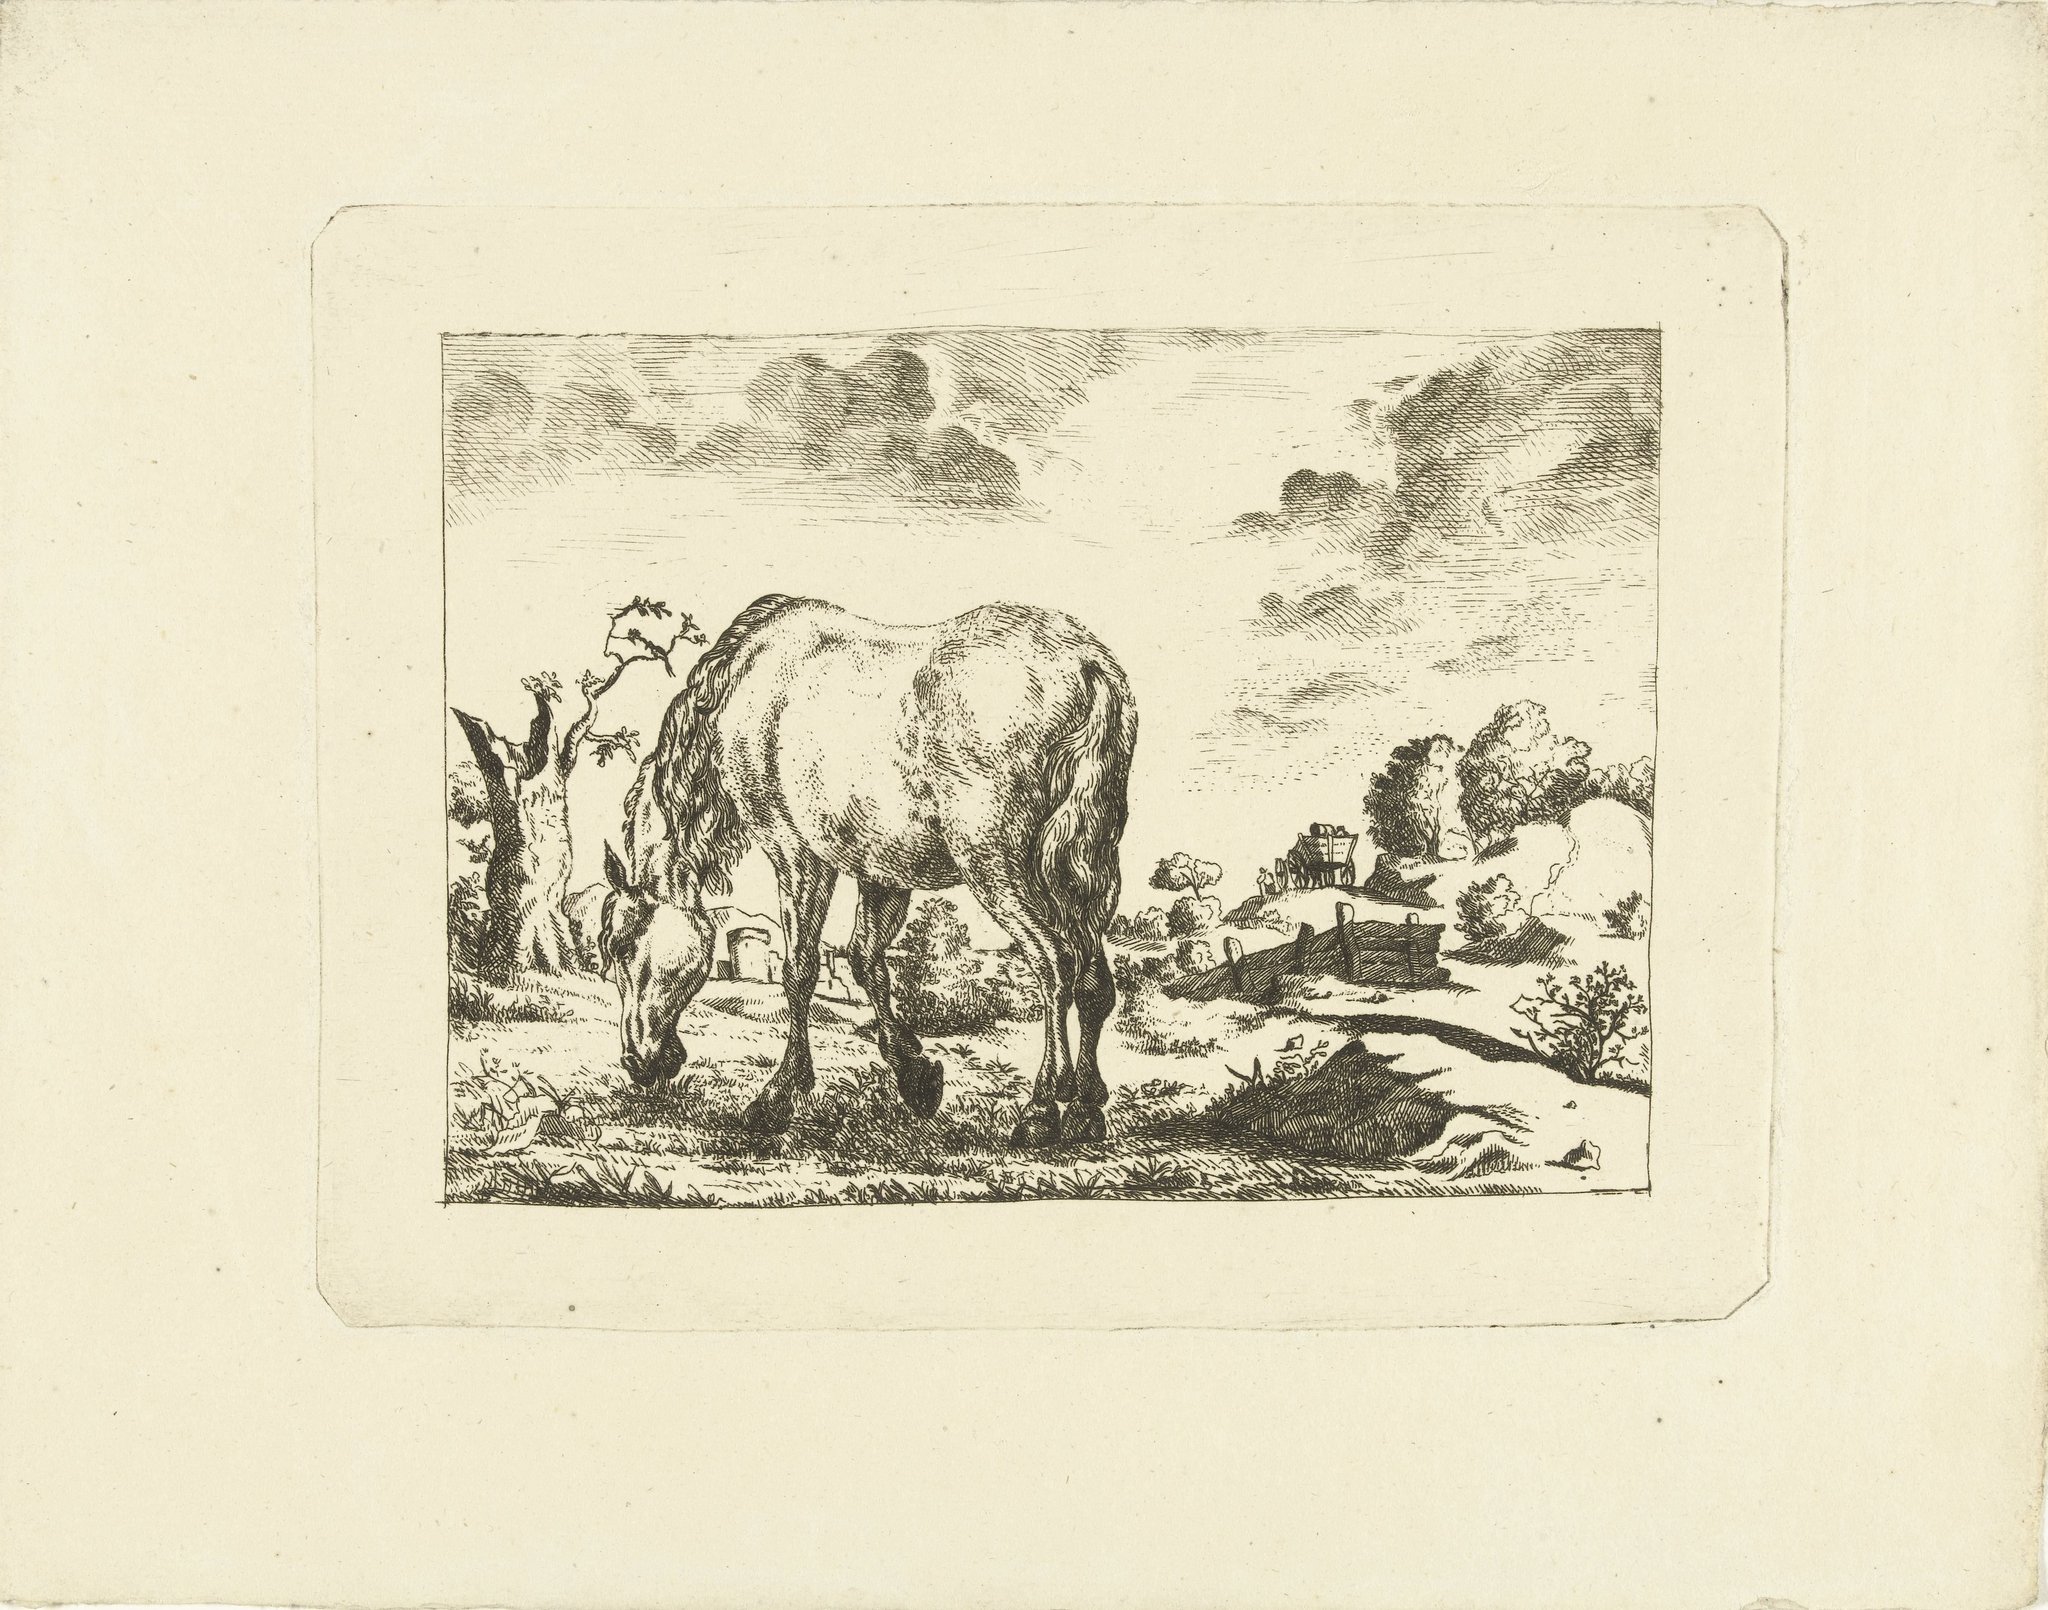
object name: print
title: Paard in een weiland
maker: g. van citters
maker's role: print maker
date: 1750-1800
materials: paper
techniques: etching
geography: netherlands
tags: horse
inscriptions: collector's mark: Lugt 2233